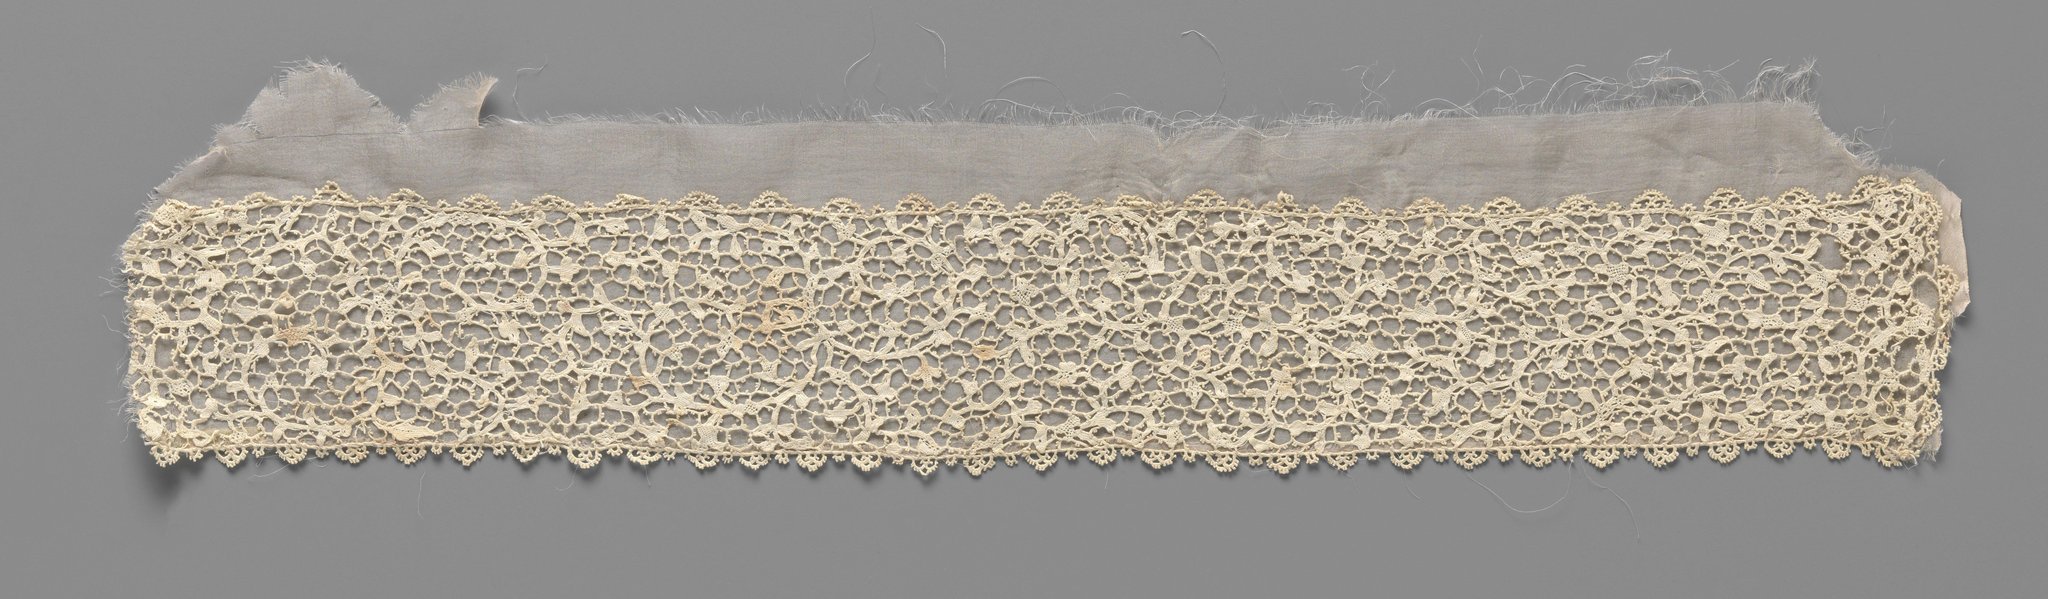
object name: lappet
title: Strook naaldkant met bloemmotieven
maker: Anonymous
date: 1690-1699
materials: linen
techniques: flat venetian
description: Strook naturelkleurig naaldkant, Venise plat. Patroon met sterk gebogen ranken en eenvoudige bloem- en bladvormen. De strook is mogelijk (een deel van) een mutsenslip. Onregelmatige spijlengrond met picots. De strook is aan één korte zijden en twee lange zijden afgewerkt met een picotrand met boogjes. Het kant is op een lichtroze stof genaaid.